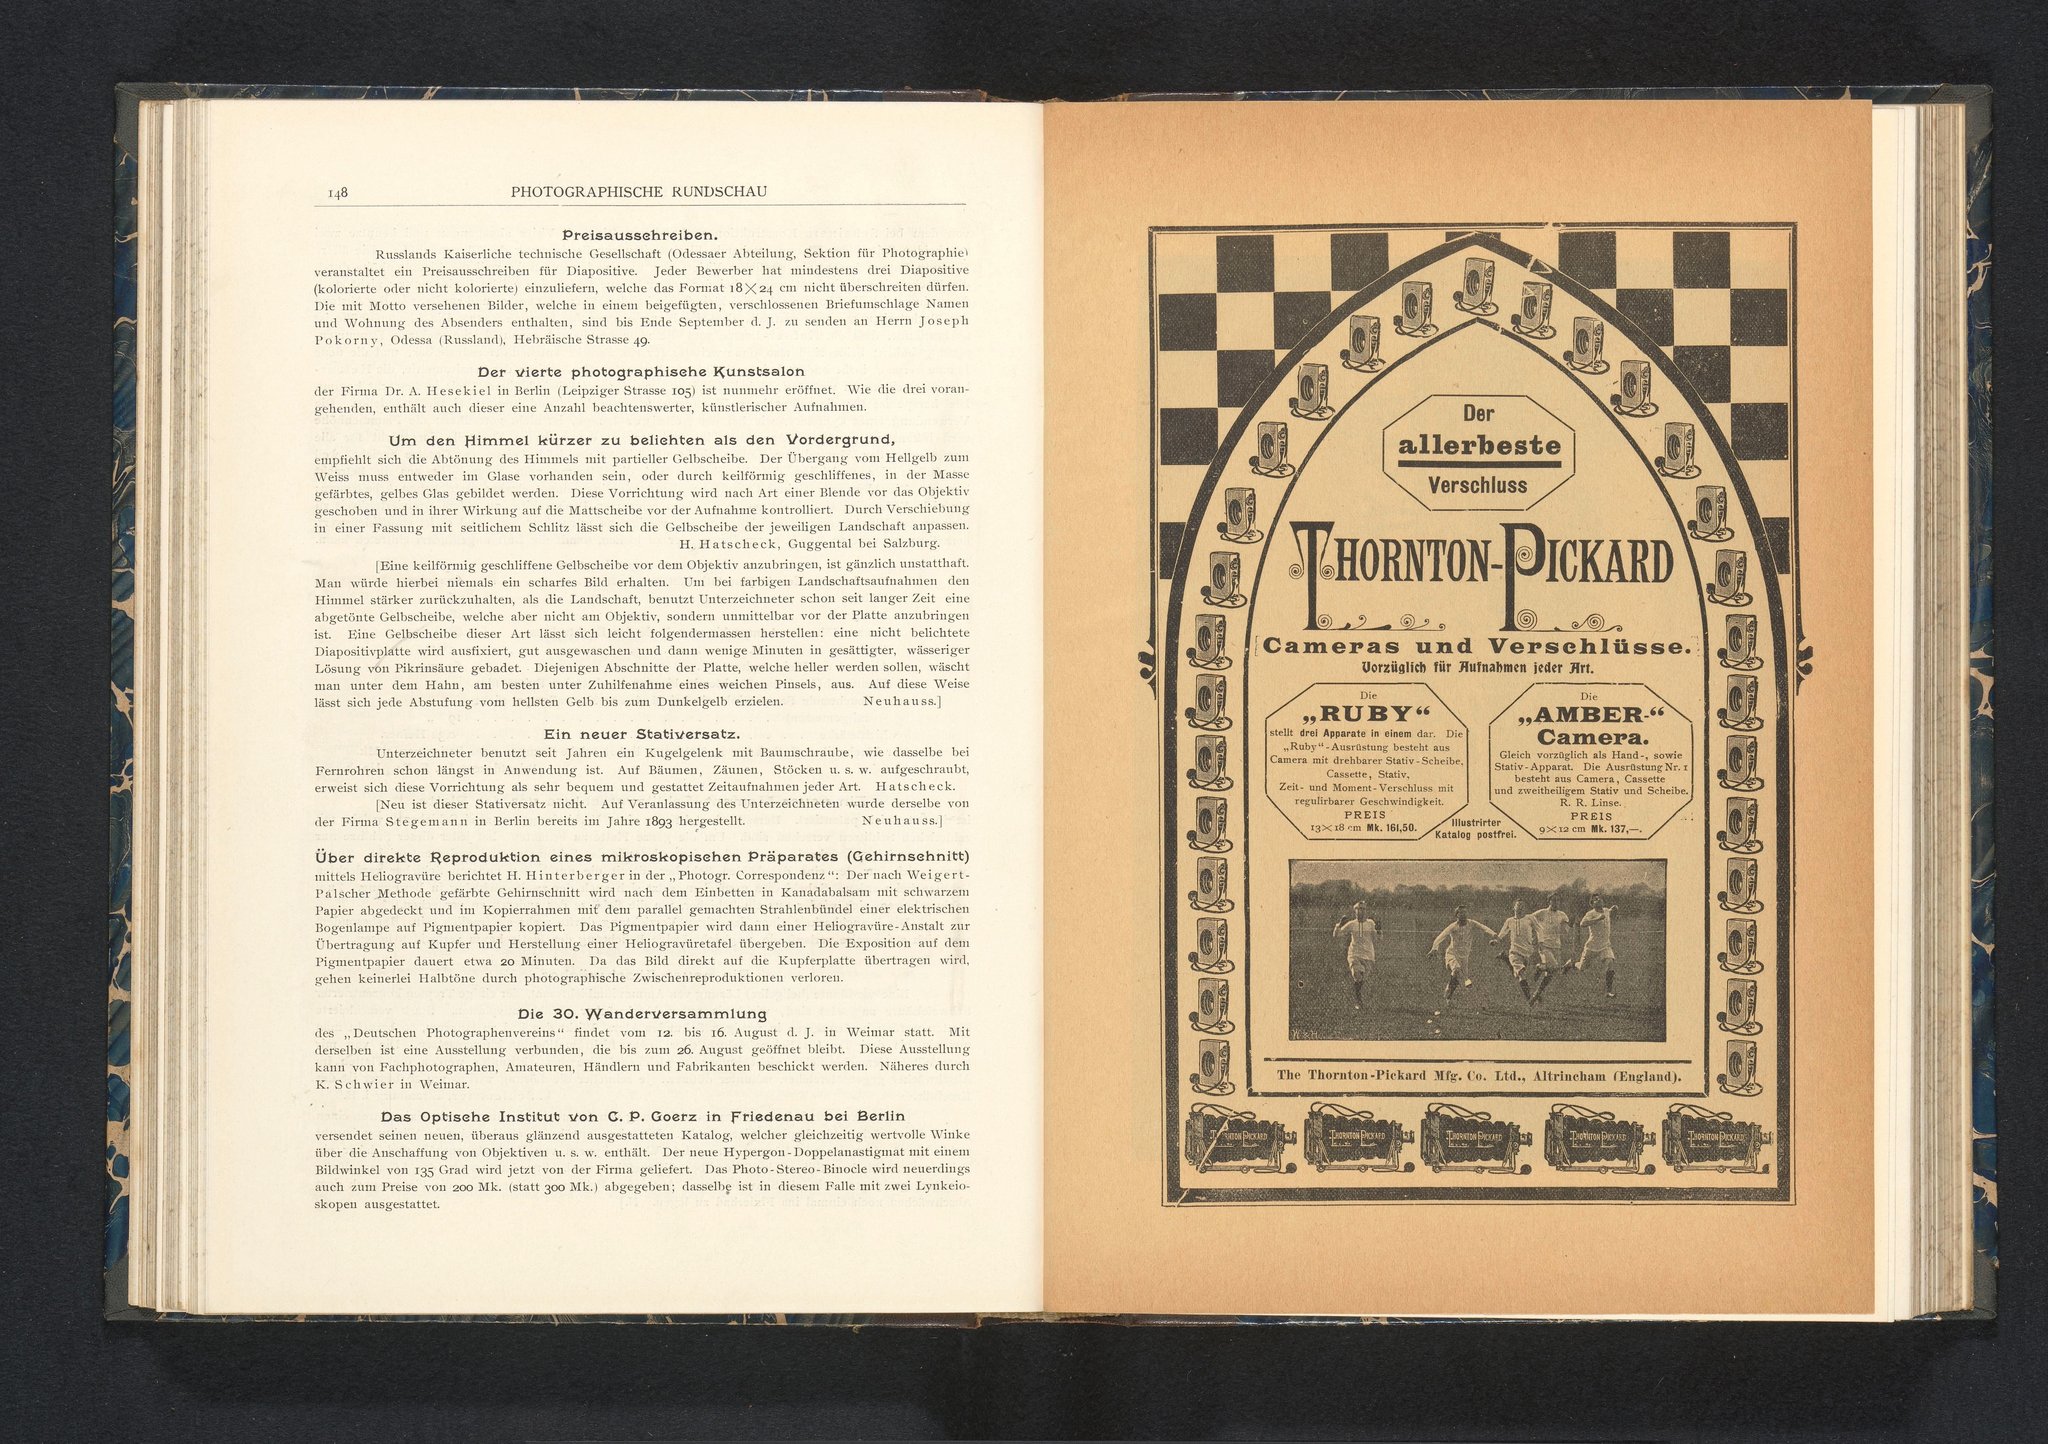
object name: photomechanical print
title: Gezicht op een groep rennende jongens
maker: Anonymous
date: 1896-1901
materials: paper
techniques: autotype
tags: youth, adolescent, running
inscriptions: monogram: ‘W&H’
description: Prent tegenover pagina 148. Onderdeel van reclame voor Thornton-Pickard.